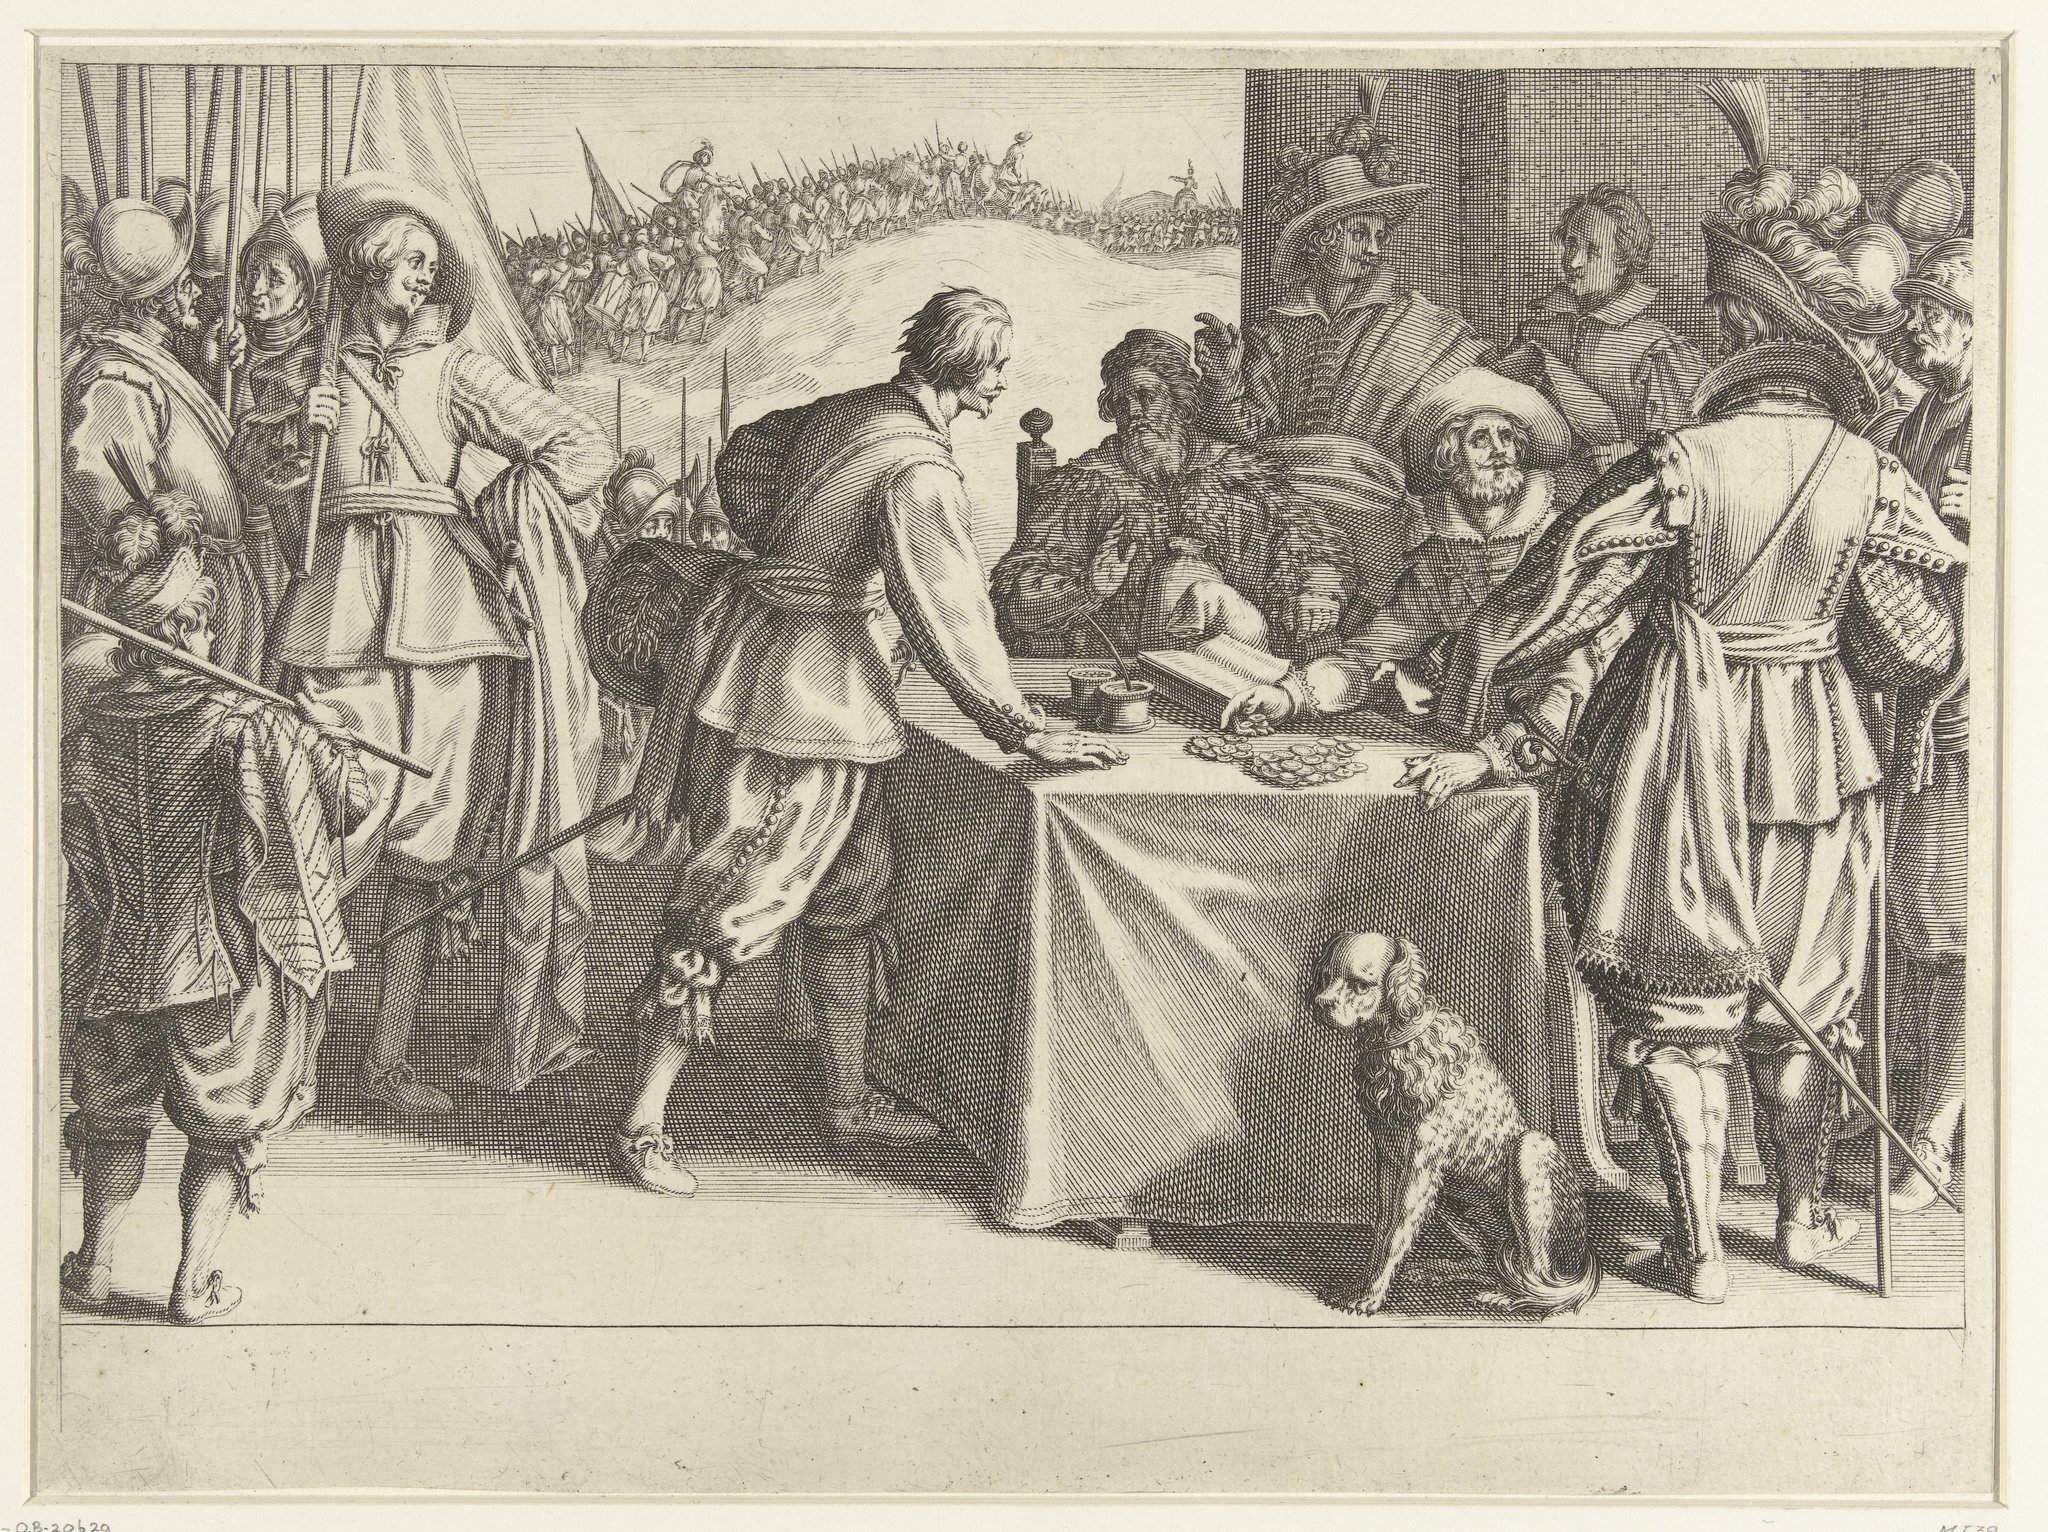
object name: print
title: Werven van troepen voor Ferdinando I de' Medici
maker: jacques callot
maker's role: draughtsman, print maker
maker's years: 1592-1635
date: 1614-1620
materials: paper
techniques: engraving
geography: florence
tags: ferdinando i de' medici, army 'en route', recruitment, dog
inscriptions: collector's mark: Lugt 240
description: Een soldaat leunt op een tafel waarachter een man zit die geld uittelt. Links meer soldaten. Op de achtergrond troepen onderweg. Onder de voorstelling een lege marge. Deze prent is onderdeel van een serie van 16 prenten (plus 2 onvoltooide prenten) van het leven van Ferdinando I de' Medici, bedoeld geweest als aanvulling op een reeds bestaande reeks illustraties van de geschiedenis van de Medicis.